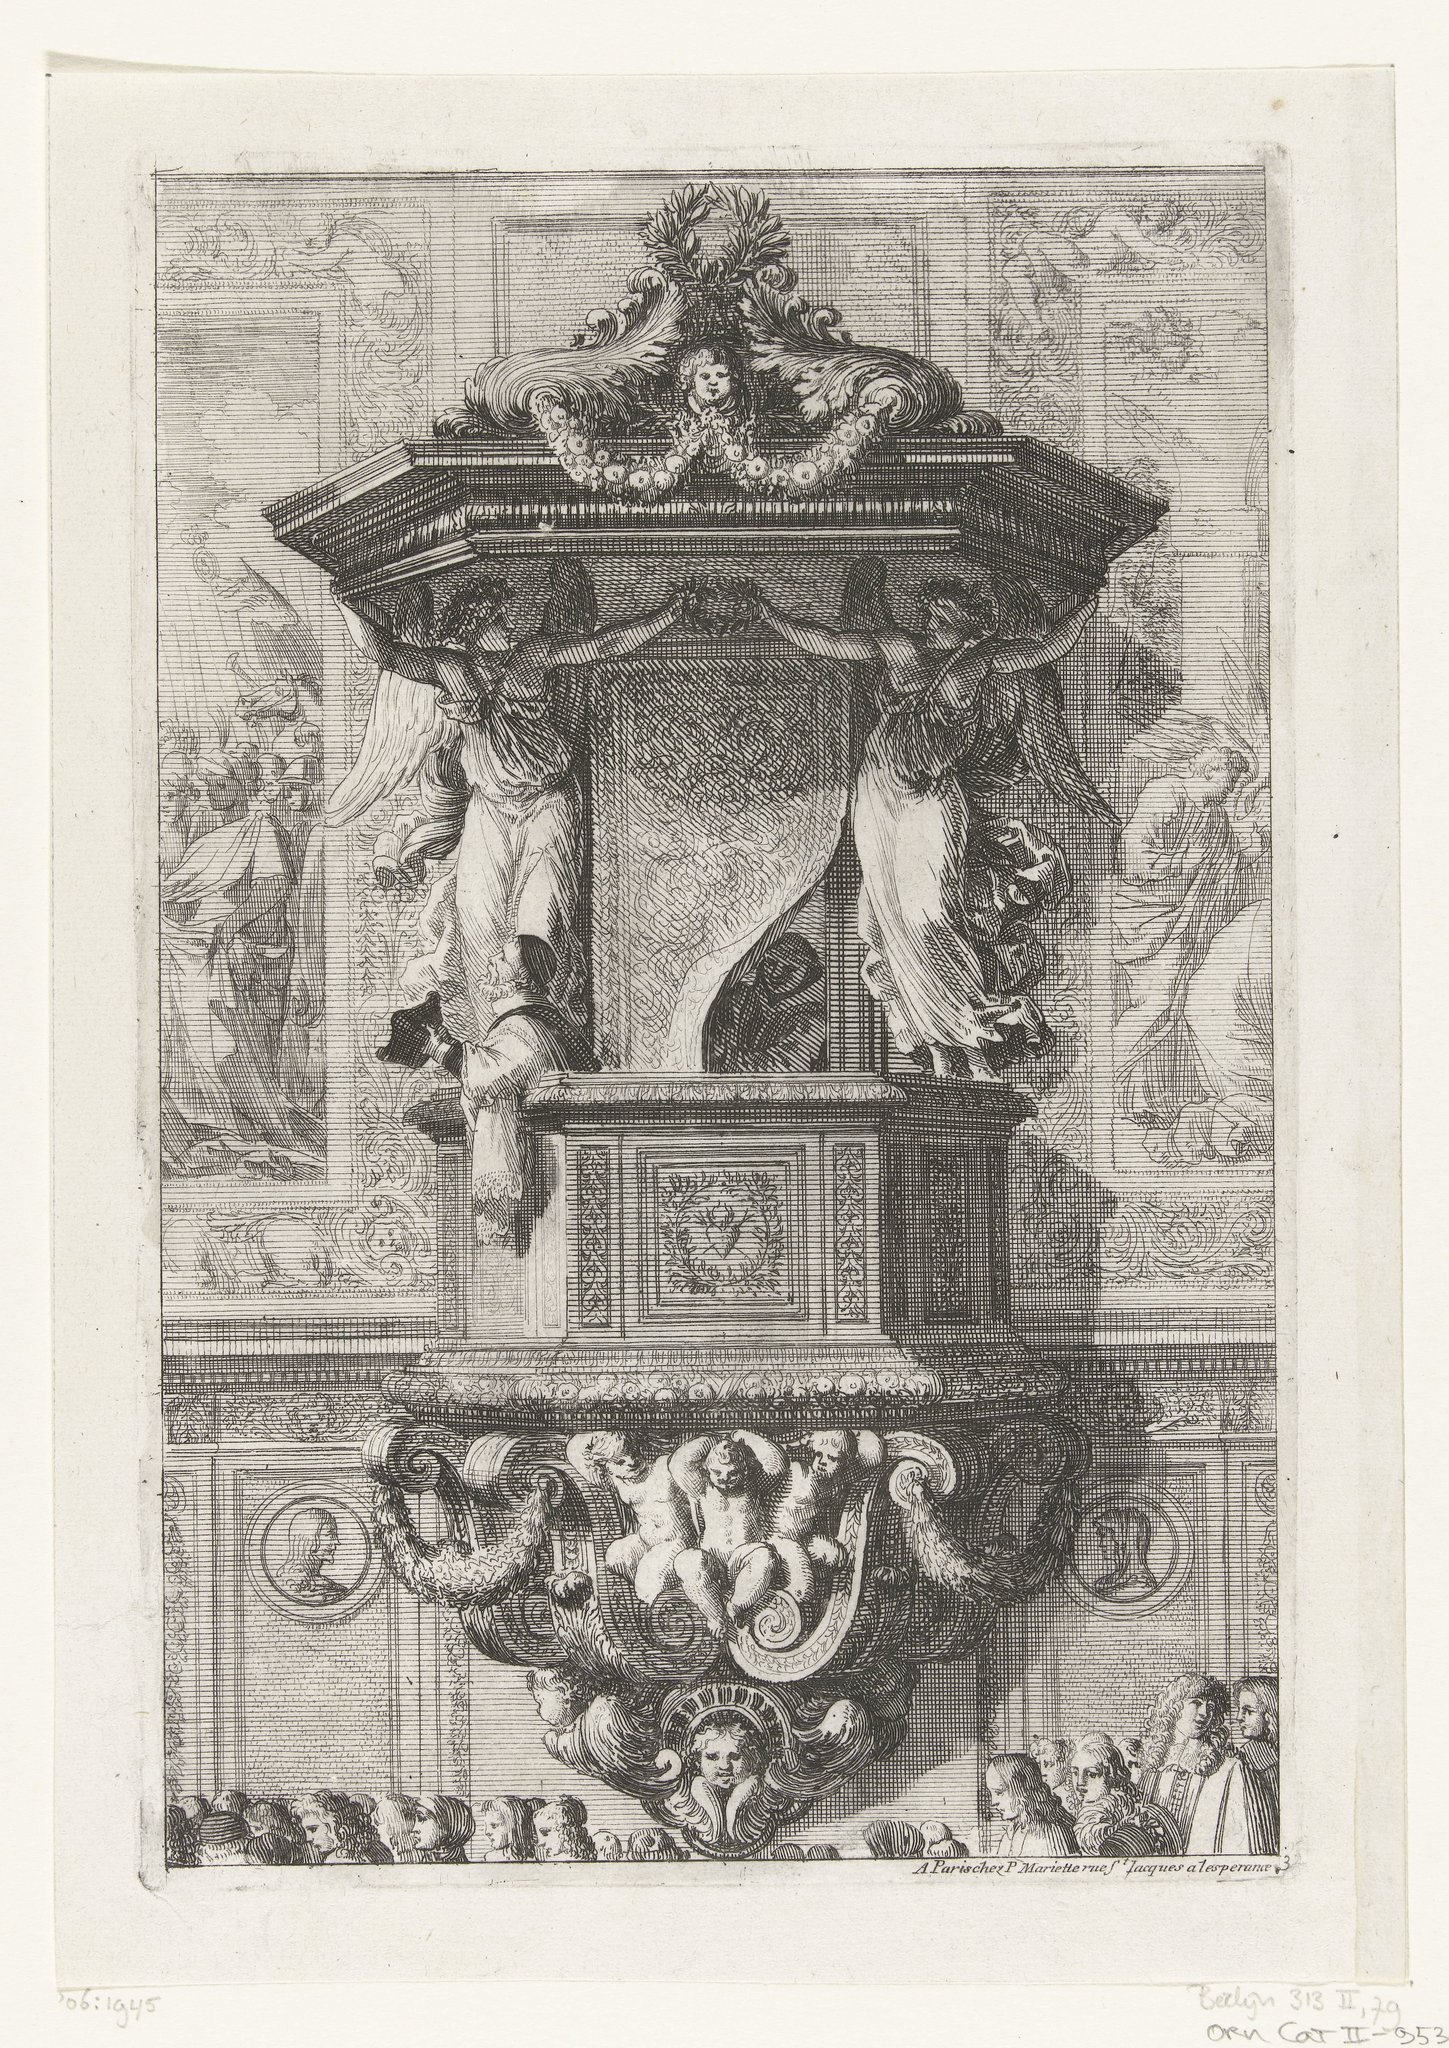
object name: ornament print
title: Kansel van voren gezien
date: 1659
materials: paper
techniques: etching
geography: paris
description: Met een hangend zeshoekig lichaam ondersteund door consoles en putti. Uit tweede editie.